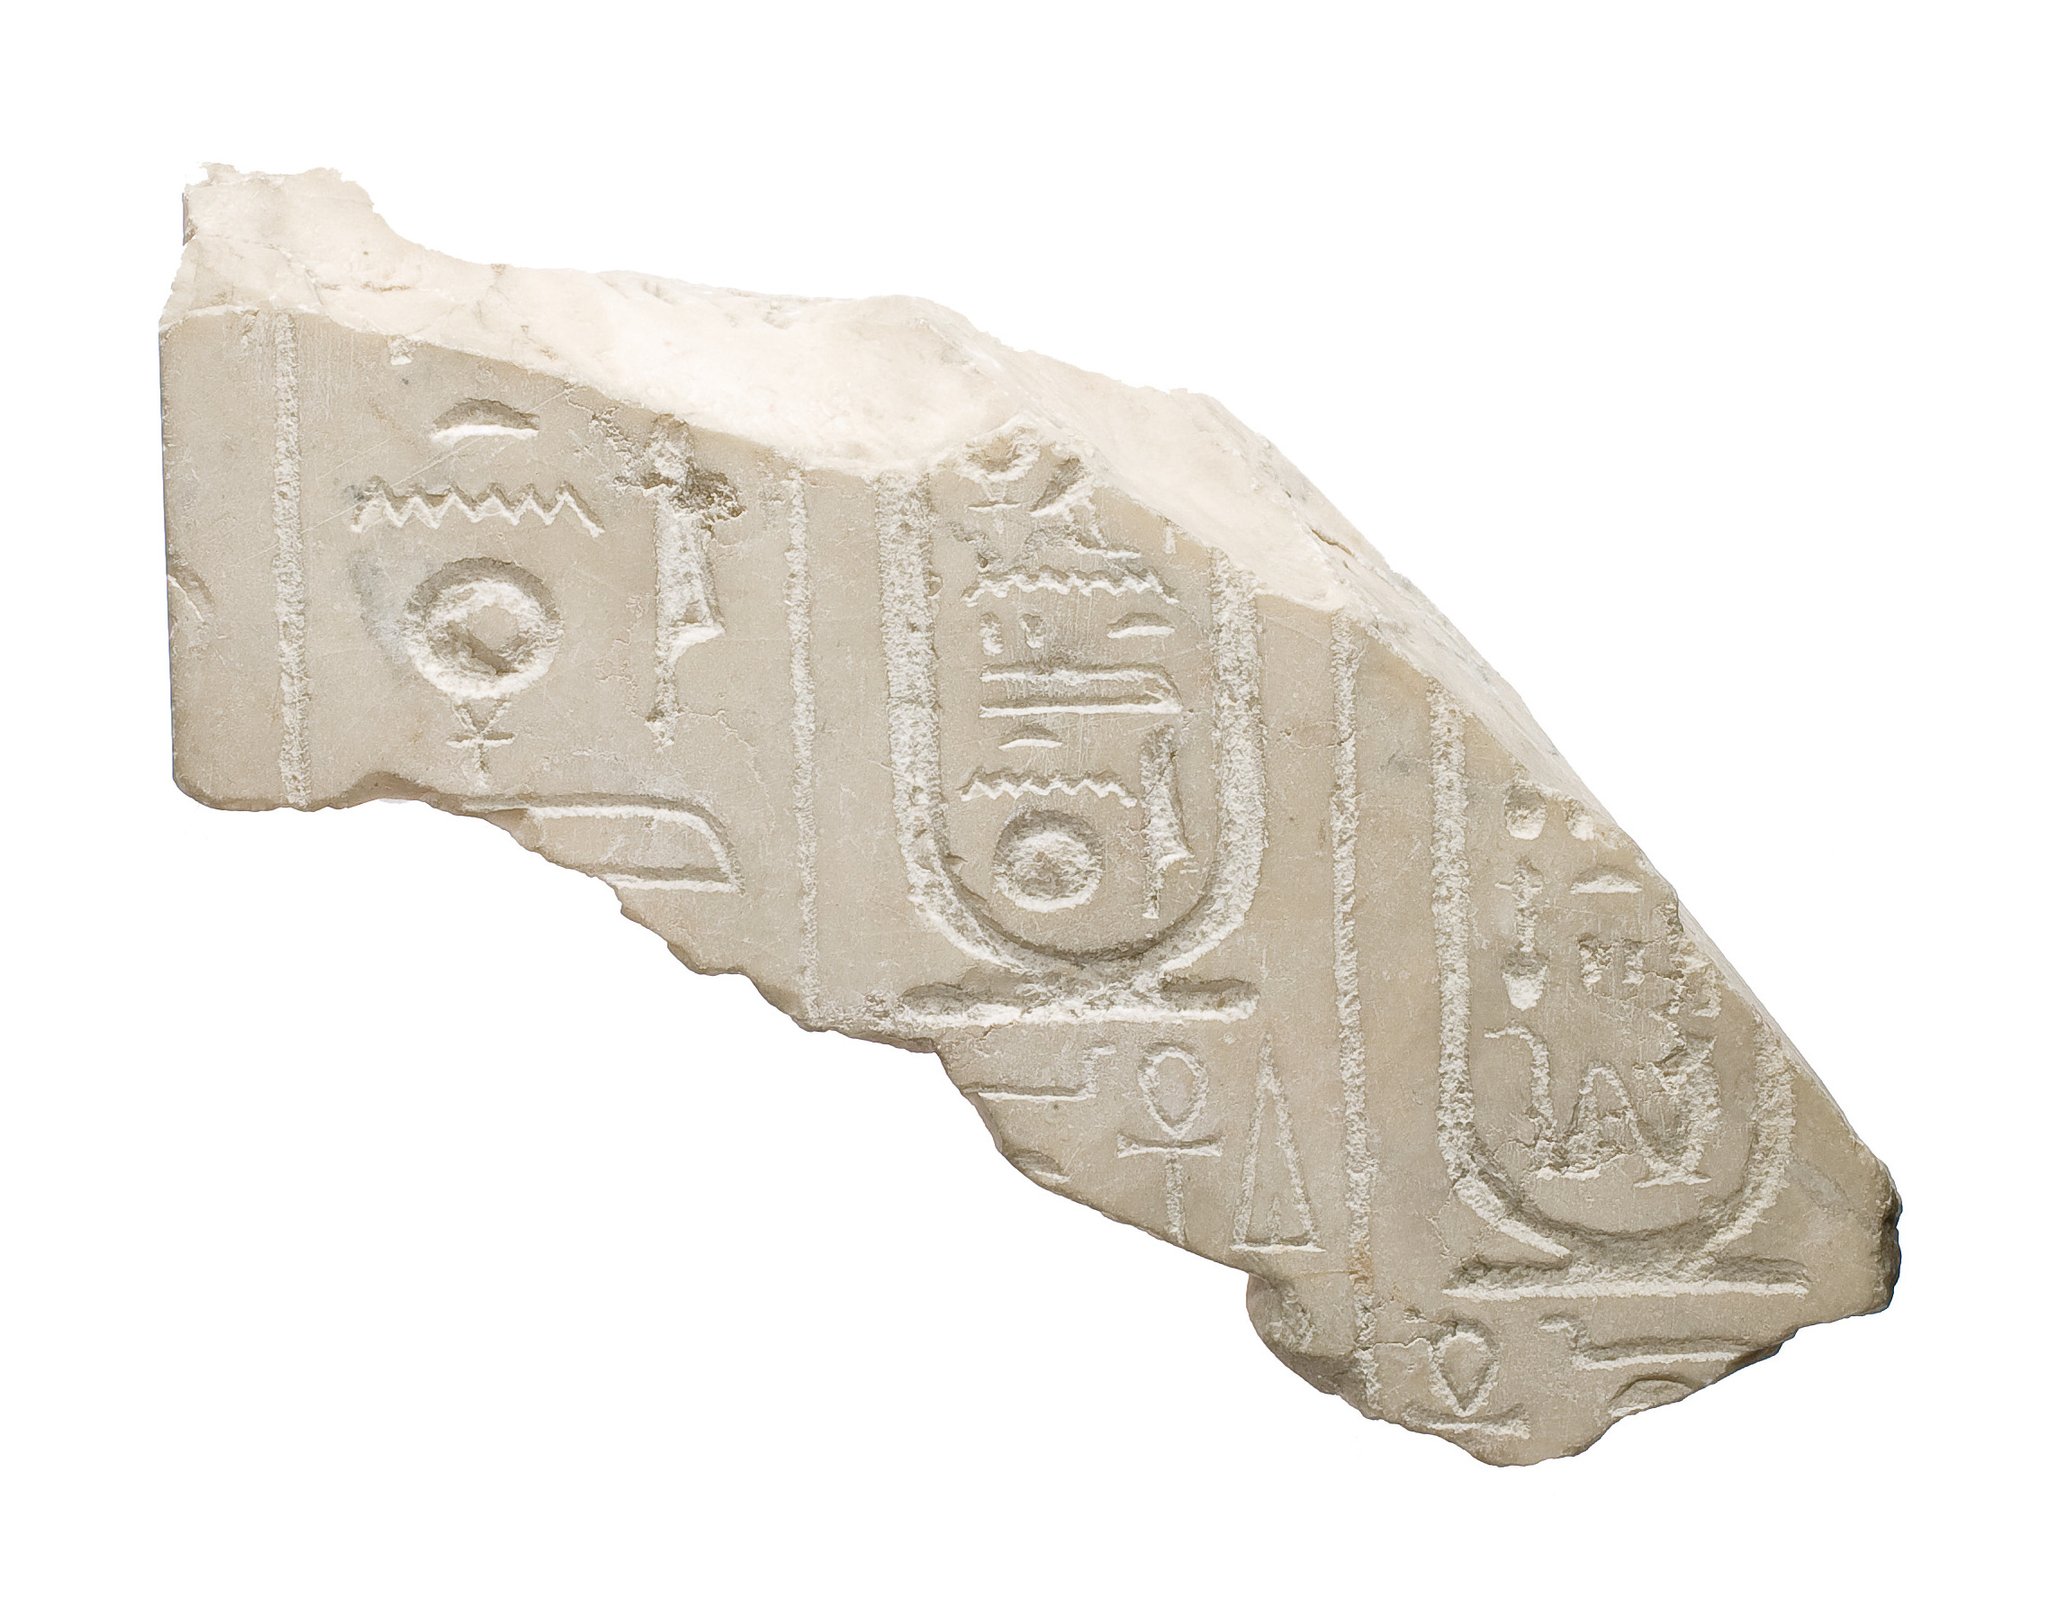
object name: inscribed fragment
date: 1353-1336 BCE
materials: limestone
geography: egypt